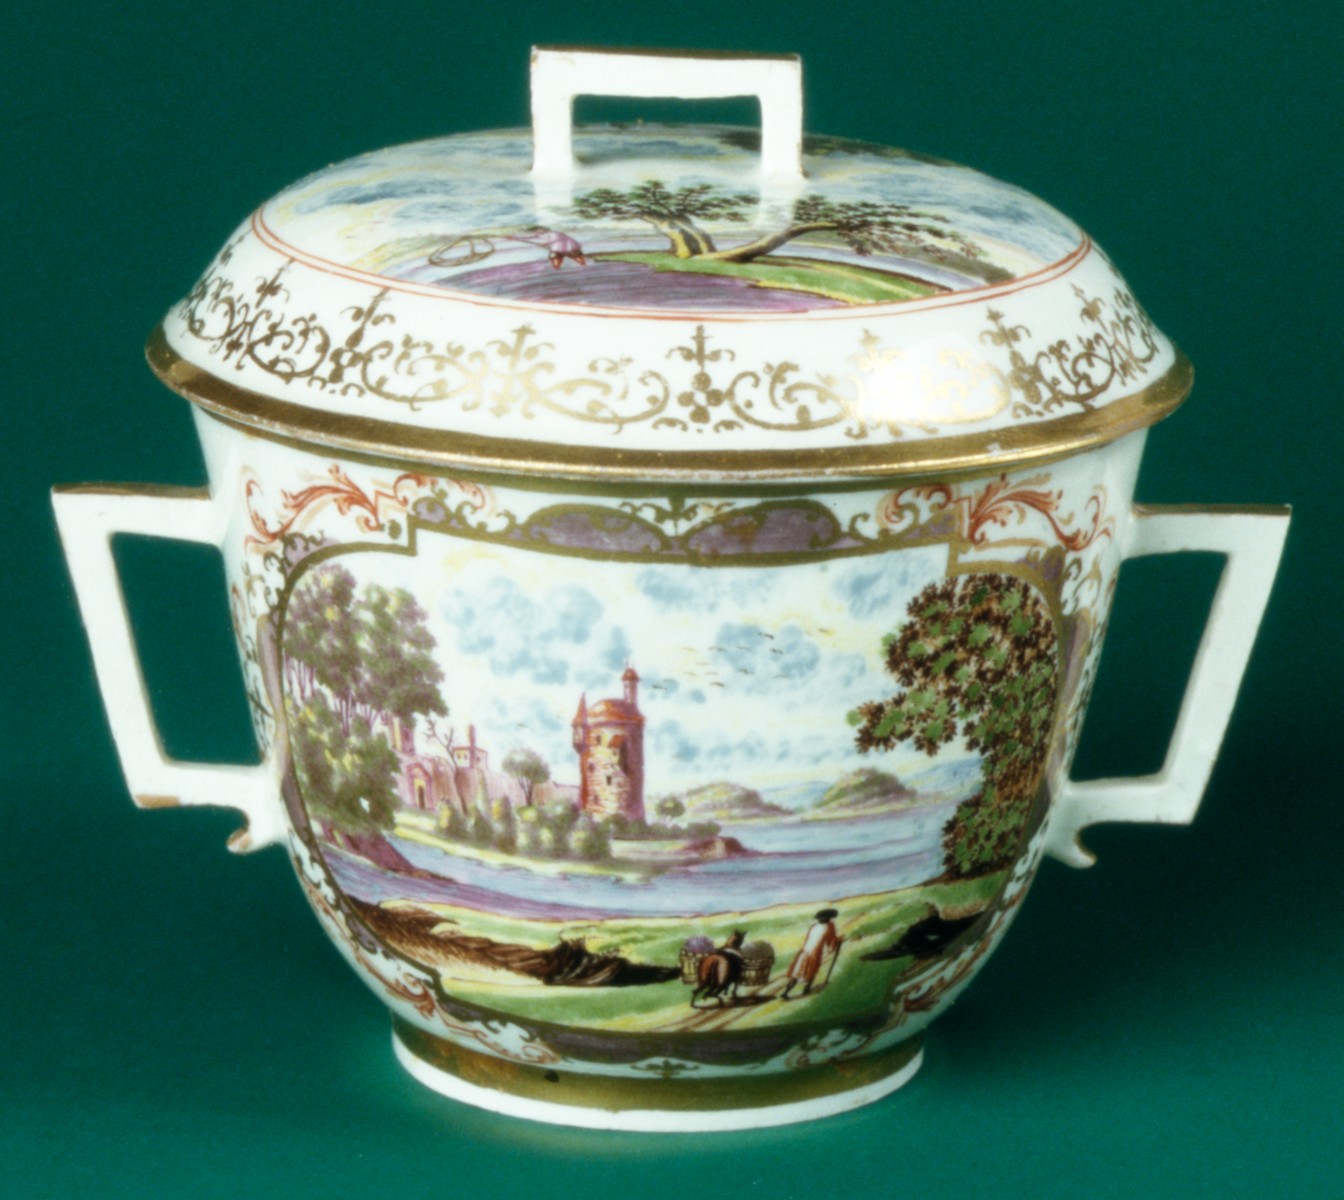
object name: bowl with cover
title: Bowl with cover (part of a set)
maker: meissen manufactory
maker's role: manufactory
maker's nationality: german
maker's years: 1710-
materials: hard paste porcelain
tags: human figures,landscapes